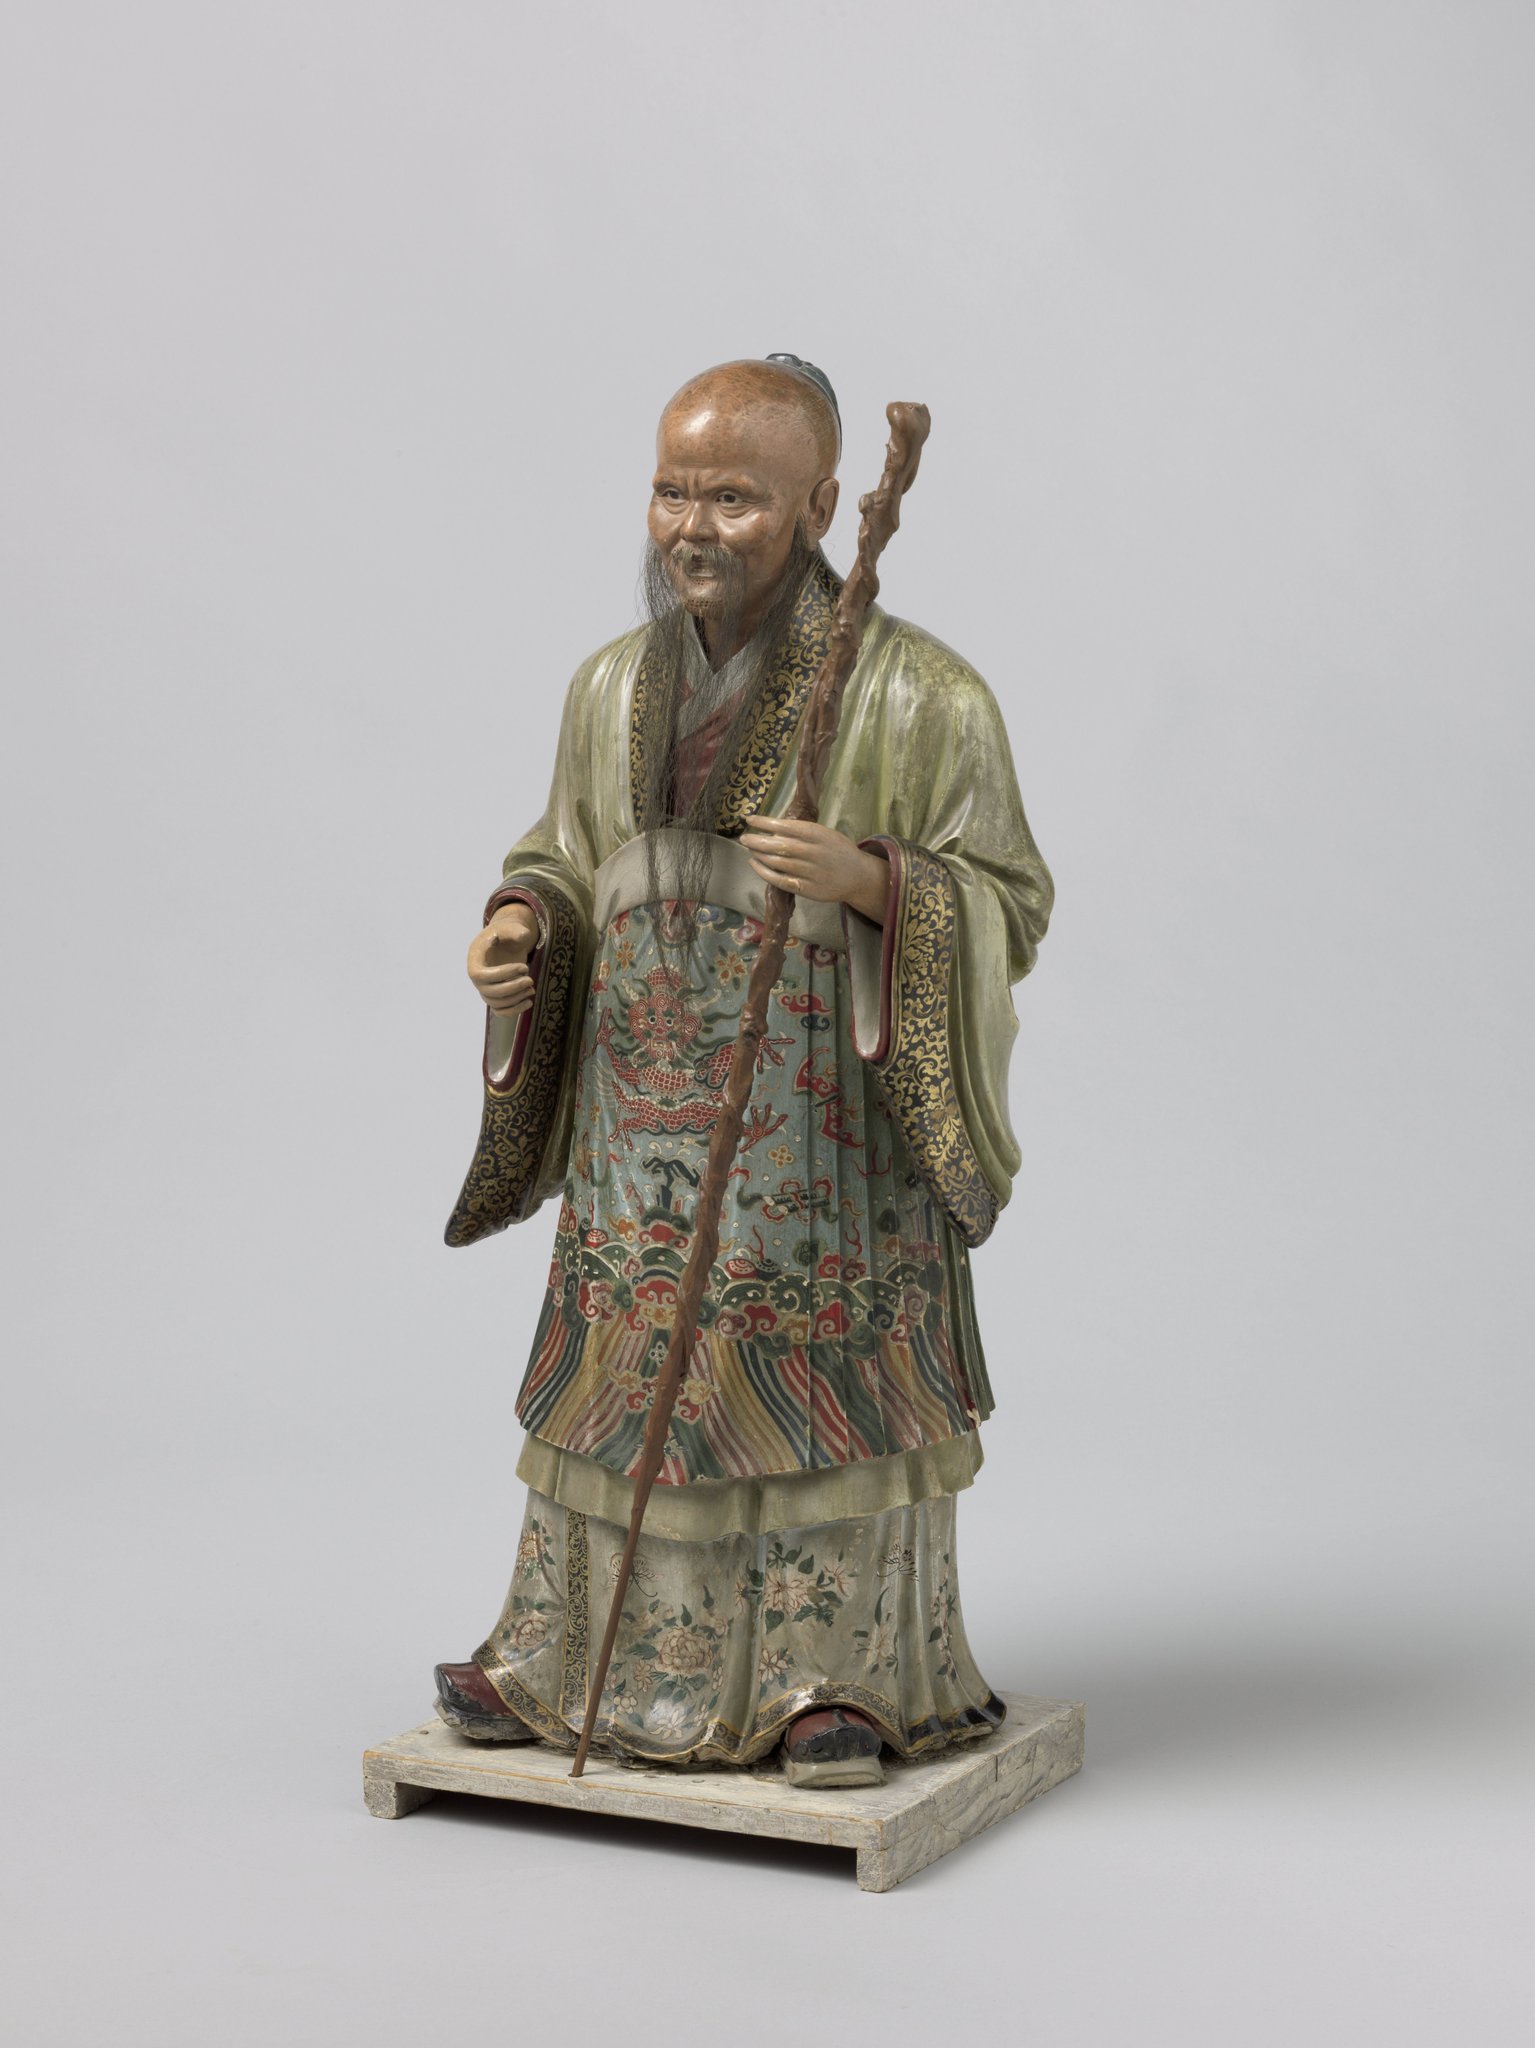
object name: doll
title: Rechterhand van een staande Chinese knikpop (man)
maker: Anonymous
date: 1804-1808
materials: hair, iron, lead, earth, porcelain, wood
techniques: woodworking, molding, polychromy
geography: china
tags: china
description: Geschenk van de Keizer van China aan A.H. van Limburg Brouwer, Lid van de Raad der Aziatische Bezittingen en Etablissementen tijdens de Bataafse Republiek.